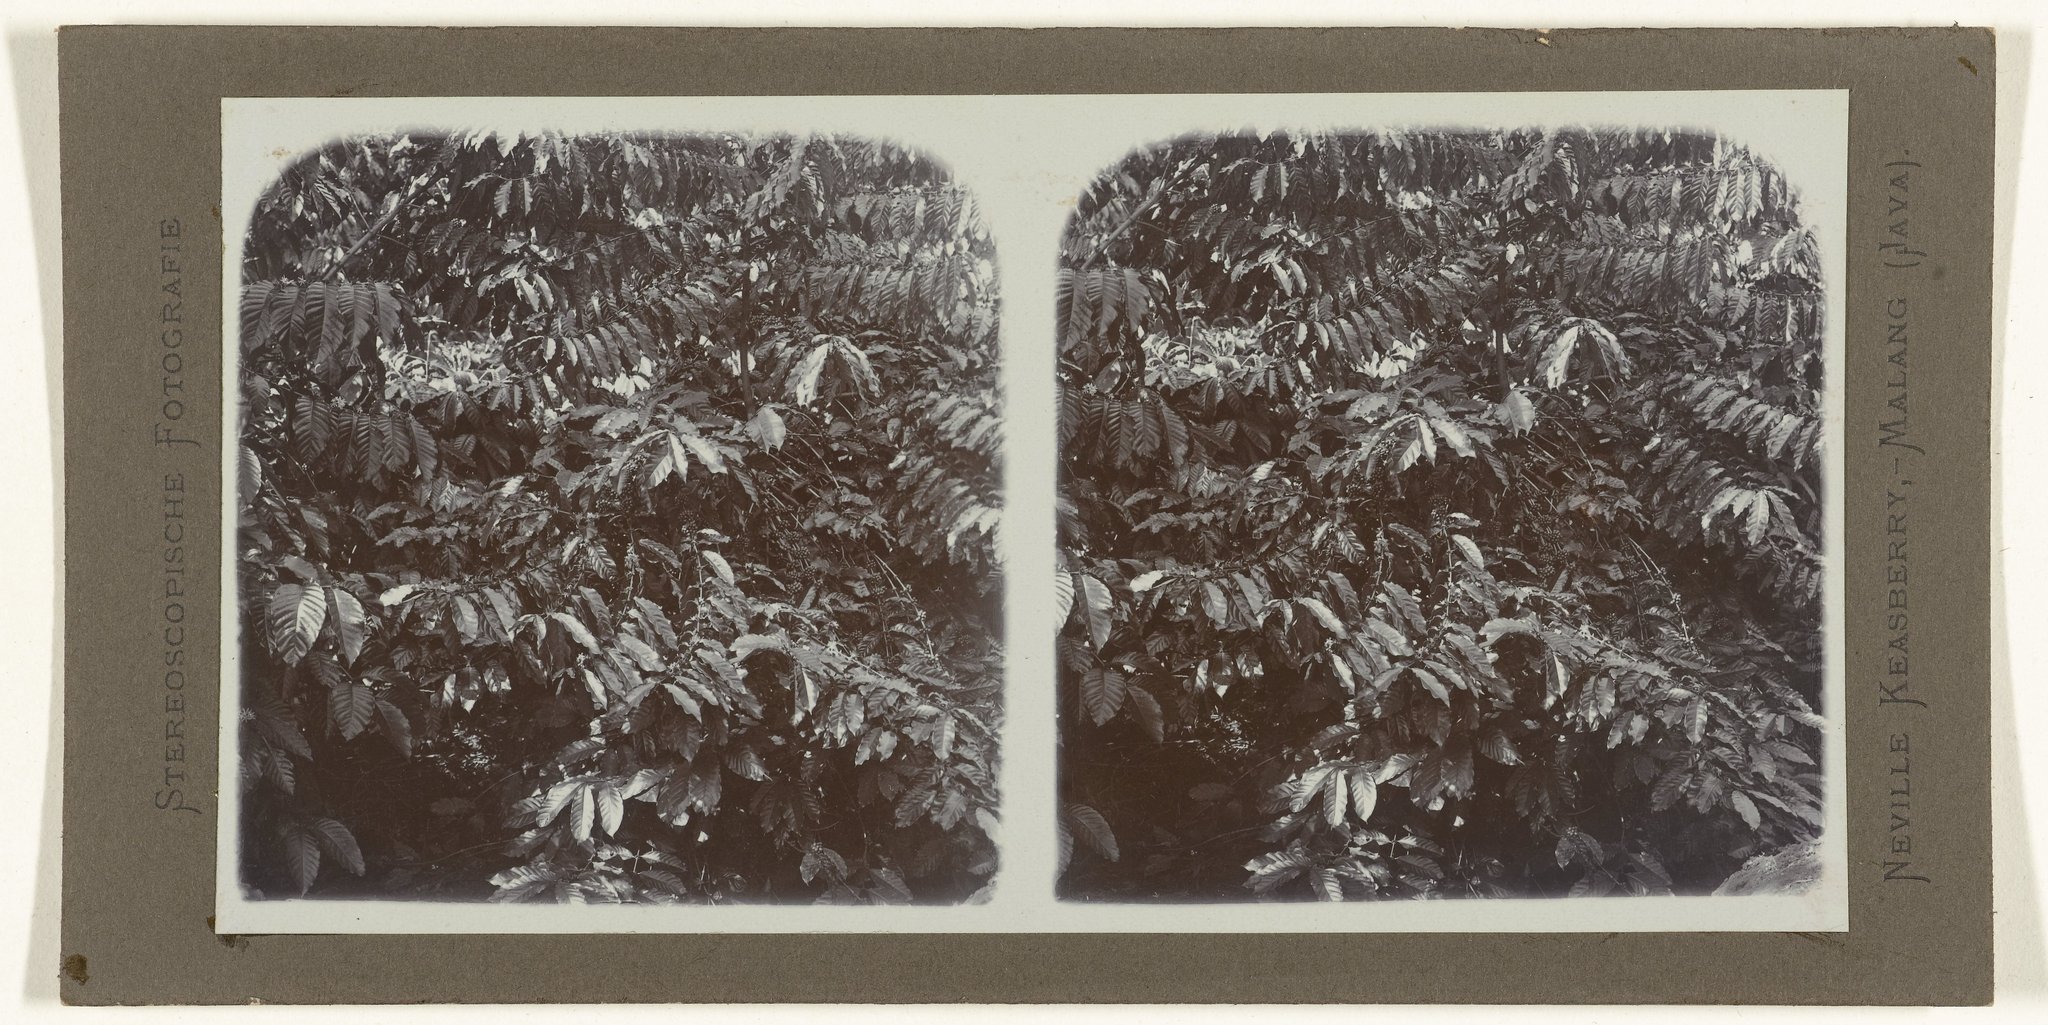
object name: stereograph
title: Vruchtdragende Robusta koffiestruik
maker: neville keasberry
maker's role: fotograaf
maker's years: 1866-1944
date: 1900-1935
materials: cardboard, paper, photographic support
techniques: albumen print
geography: malang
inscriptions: signature: ‘Neville Keasberry, Malang (Java)’, inscription: ‘Stereoscopische Fotografie’, title: ‘S 7 No 81. Koffiecultuur. Een vruchtdragende Robusta.’